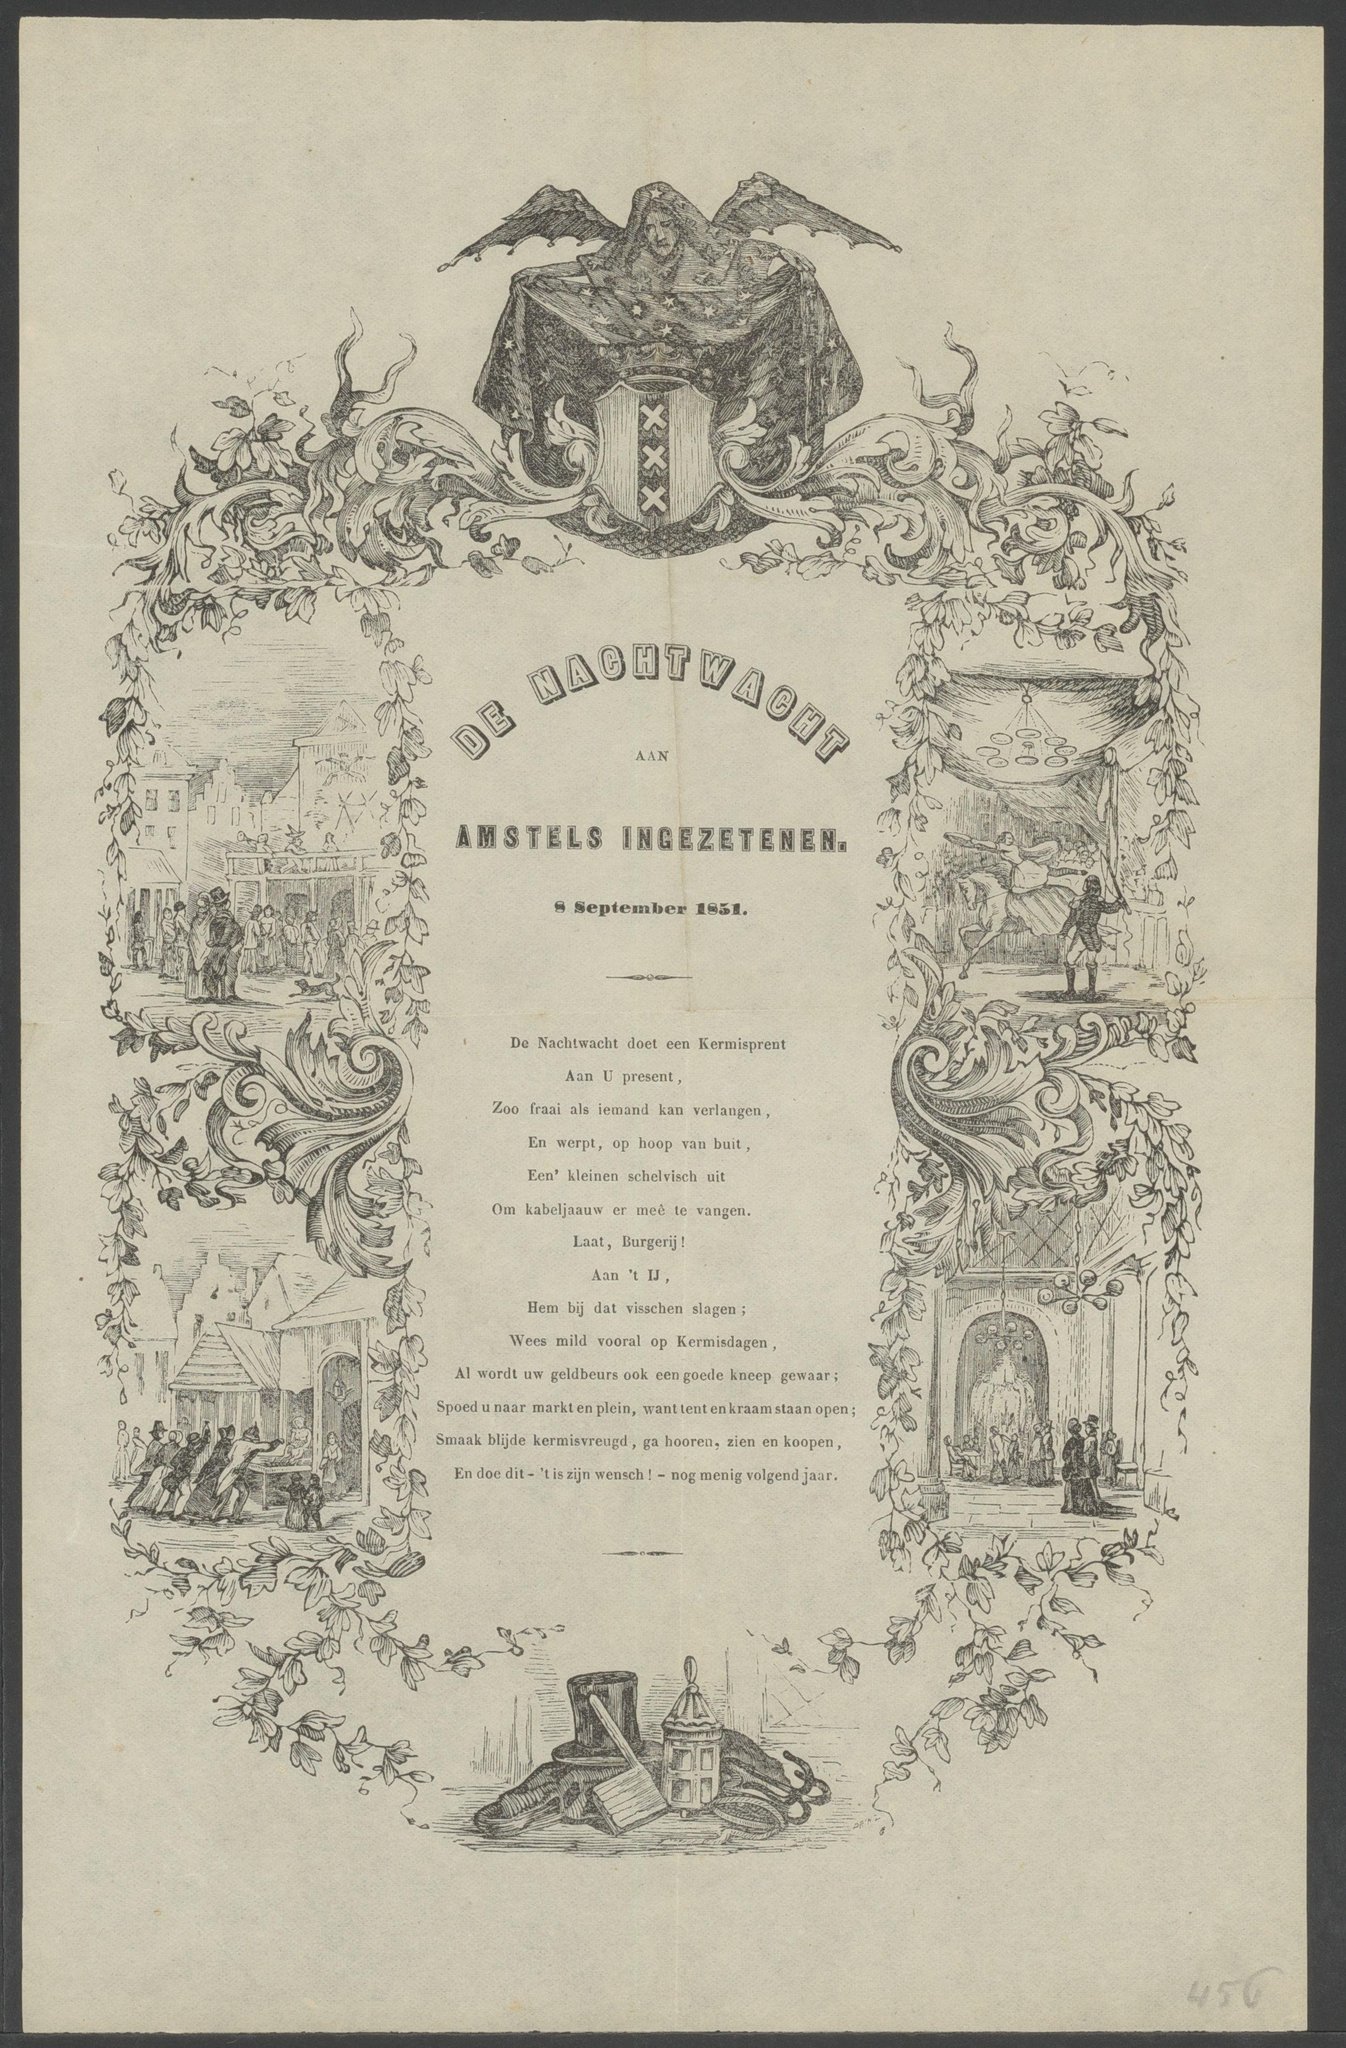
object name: print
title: De nachtwacht aan Amstels ingezetenen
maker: Anonymous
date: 1851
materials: paper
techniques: letterpress printing, engraving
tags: night patrol, amsterdam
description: Kermisprent van de Amsterdamse nachtwacht, 8 september 1851. Centraal een gedicht met bovenaan het wapen van Amsterdam en een gevleugelde vrouw. Aan de zijkanten verschillende gezichten op de kermis. Onderwerpsrubrieken binnen de Atlas Zeden en Gewoonten: Zeden en gewoonten in engeren zin, Volksleven, Volksbladen, Nieuwjaars- en Kerstwenschen, Amsterdam.